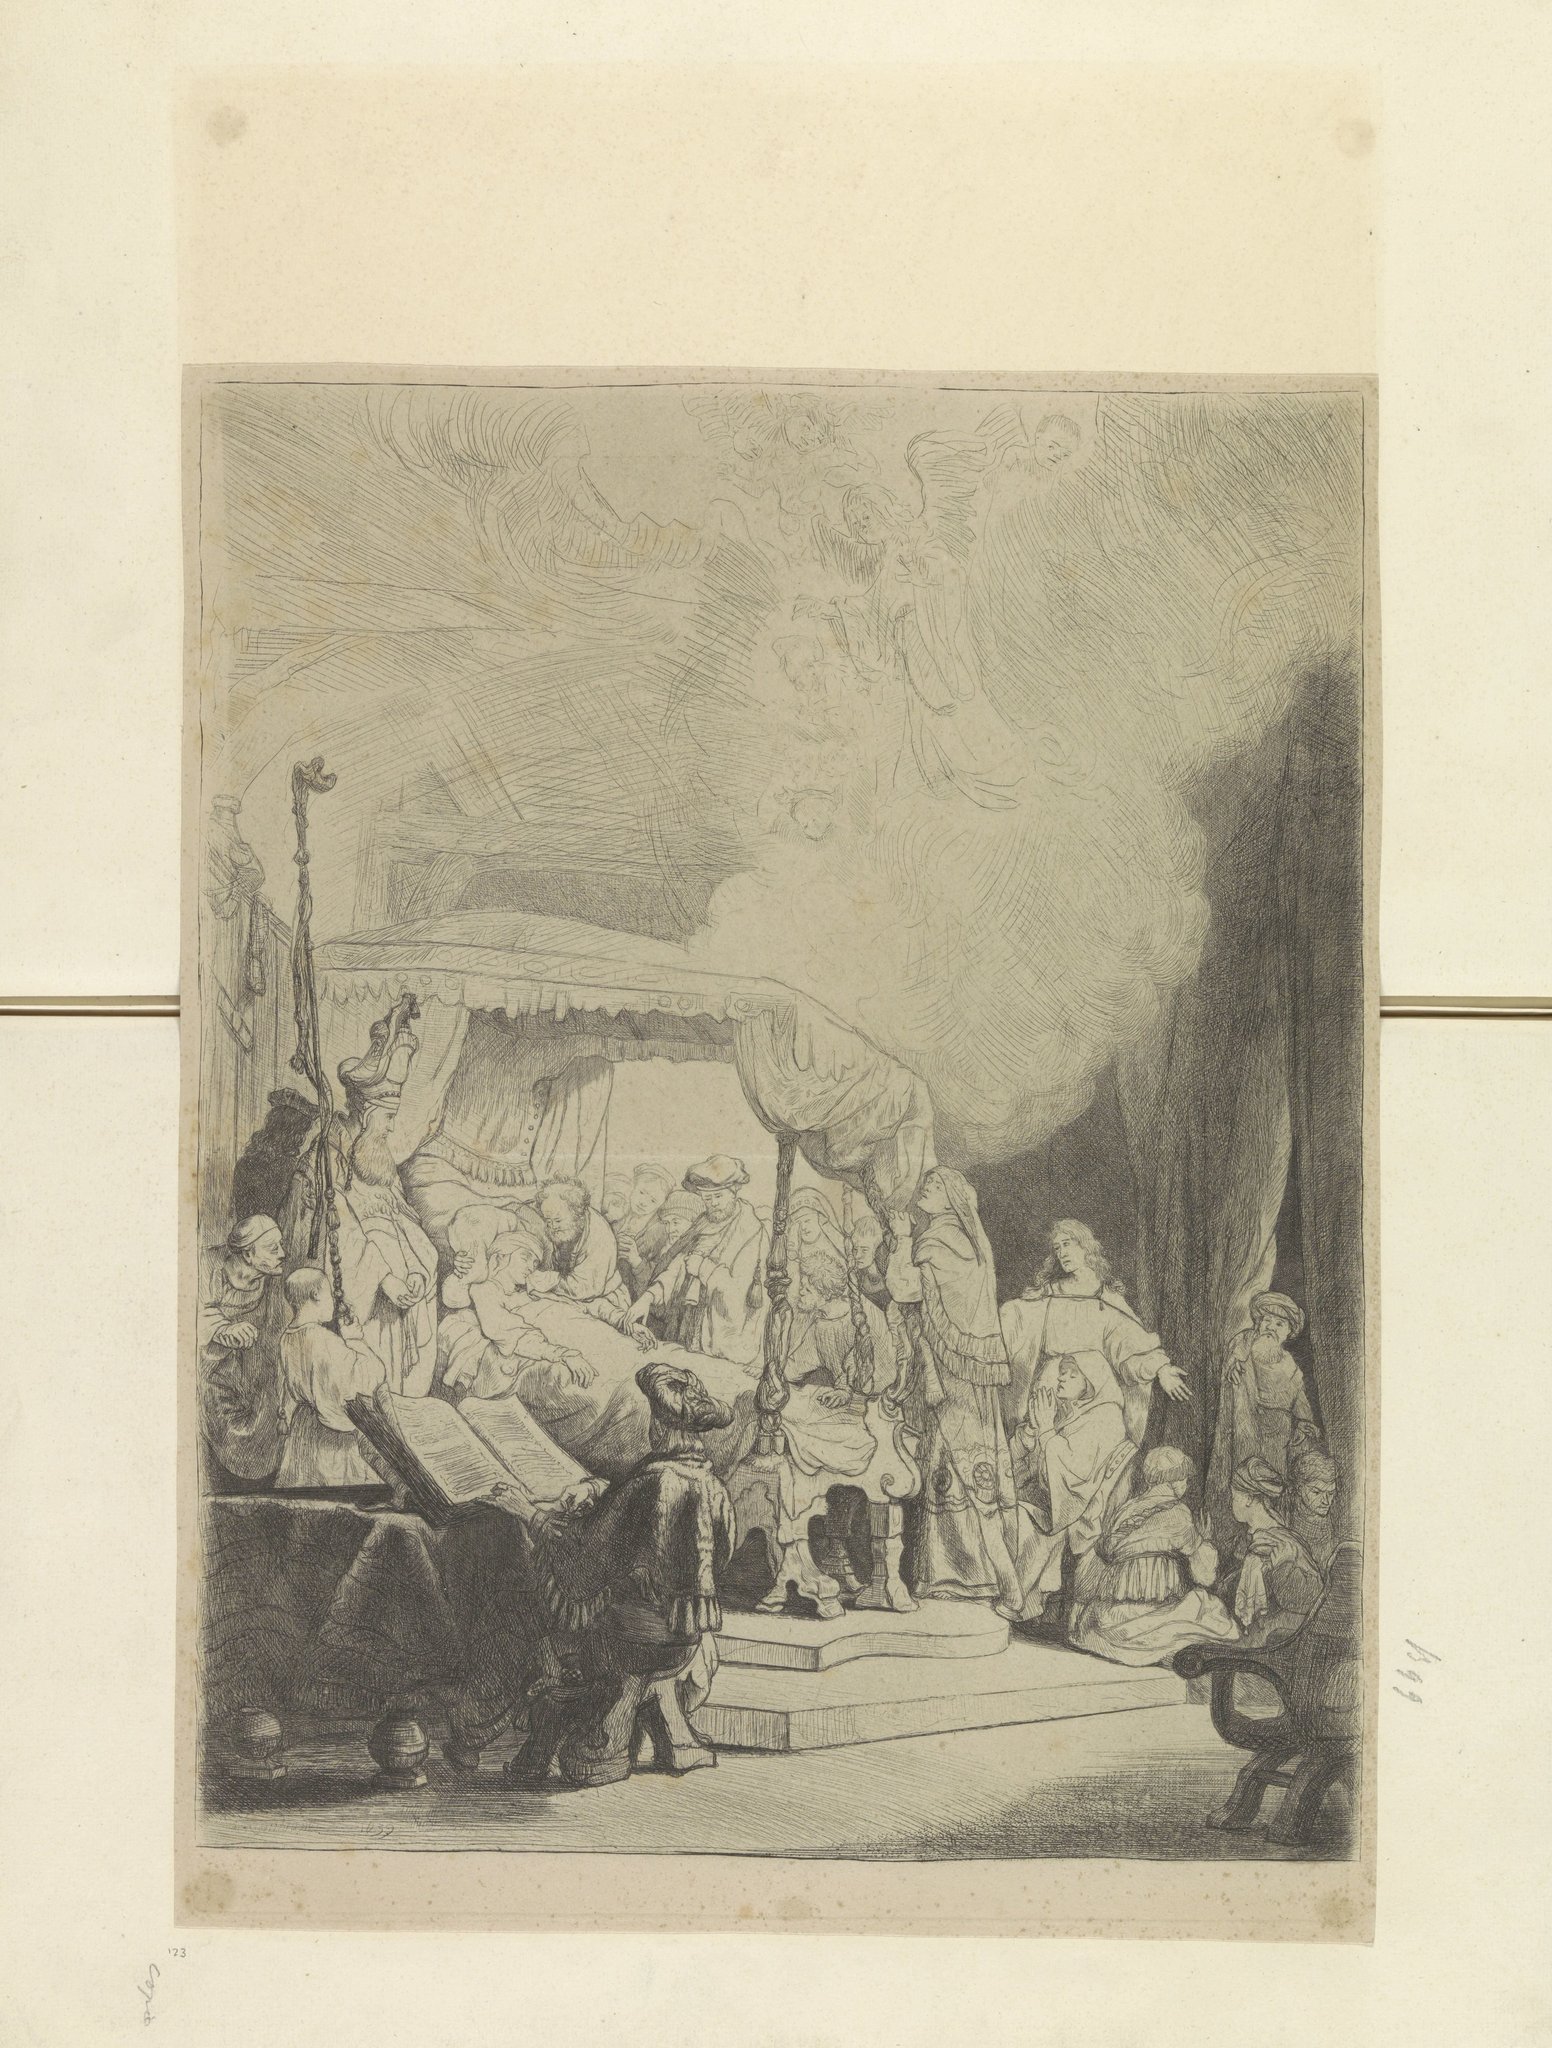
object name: print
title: Sterfbed van Maria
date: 1639-1807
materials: paper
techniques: drypoint, etching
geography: paris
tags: the dormition: mary on her deathbed; the apostles are gathered around her (john the evangelist may be shown sleeping or dreaming)